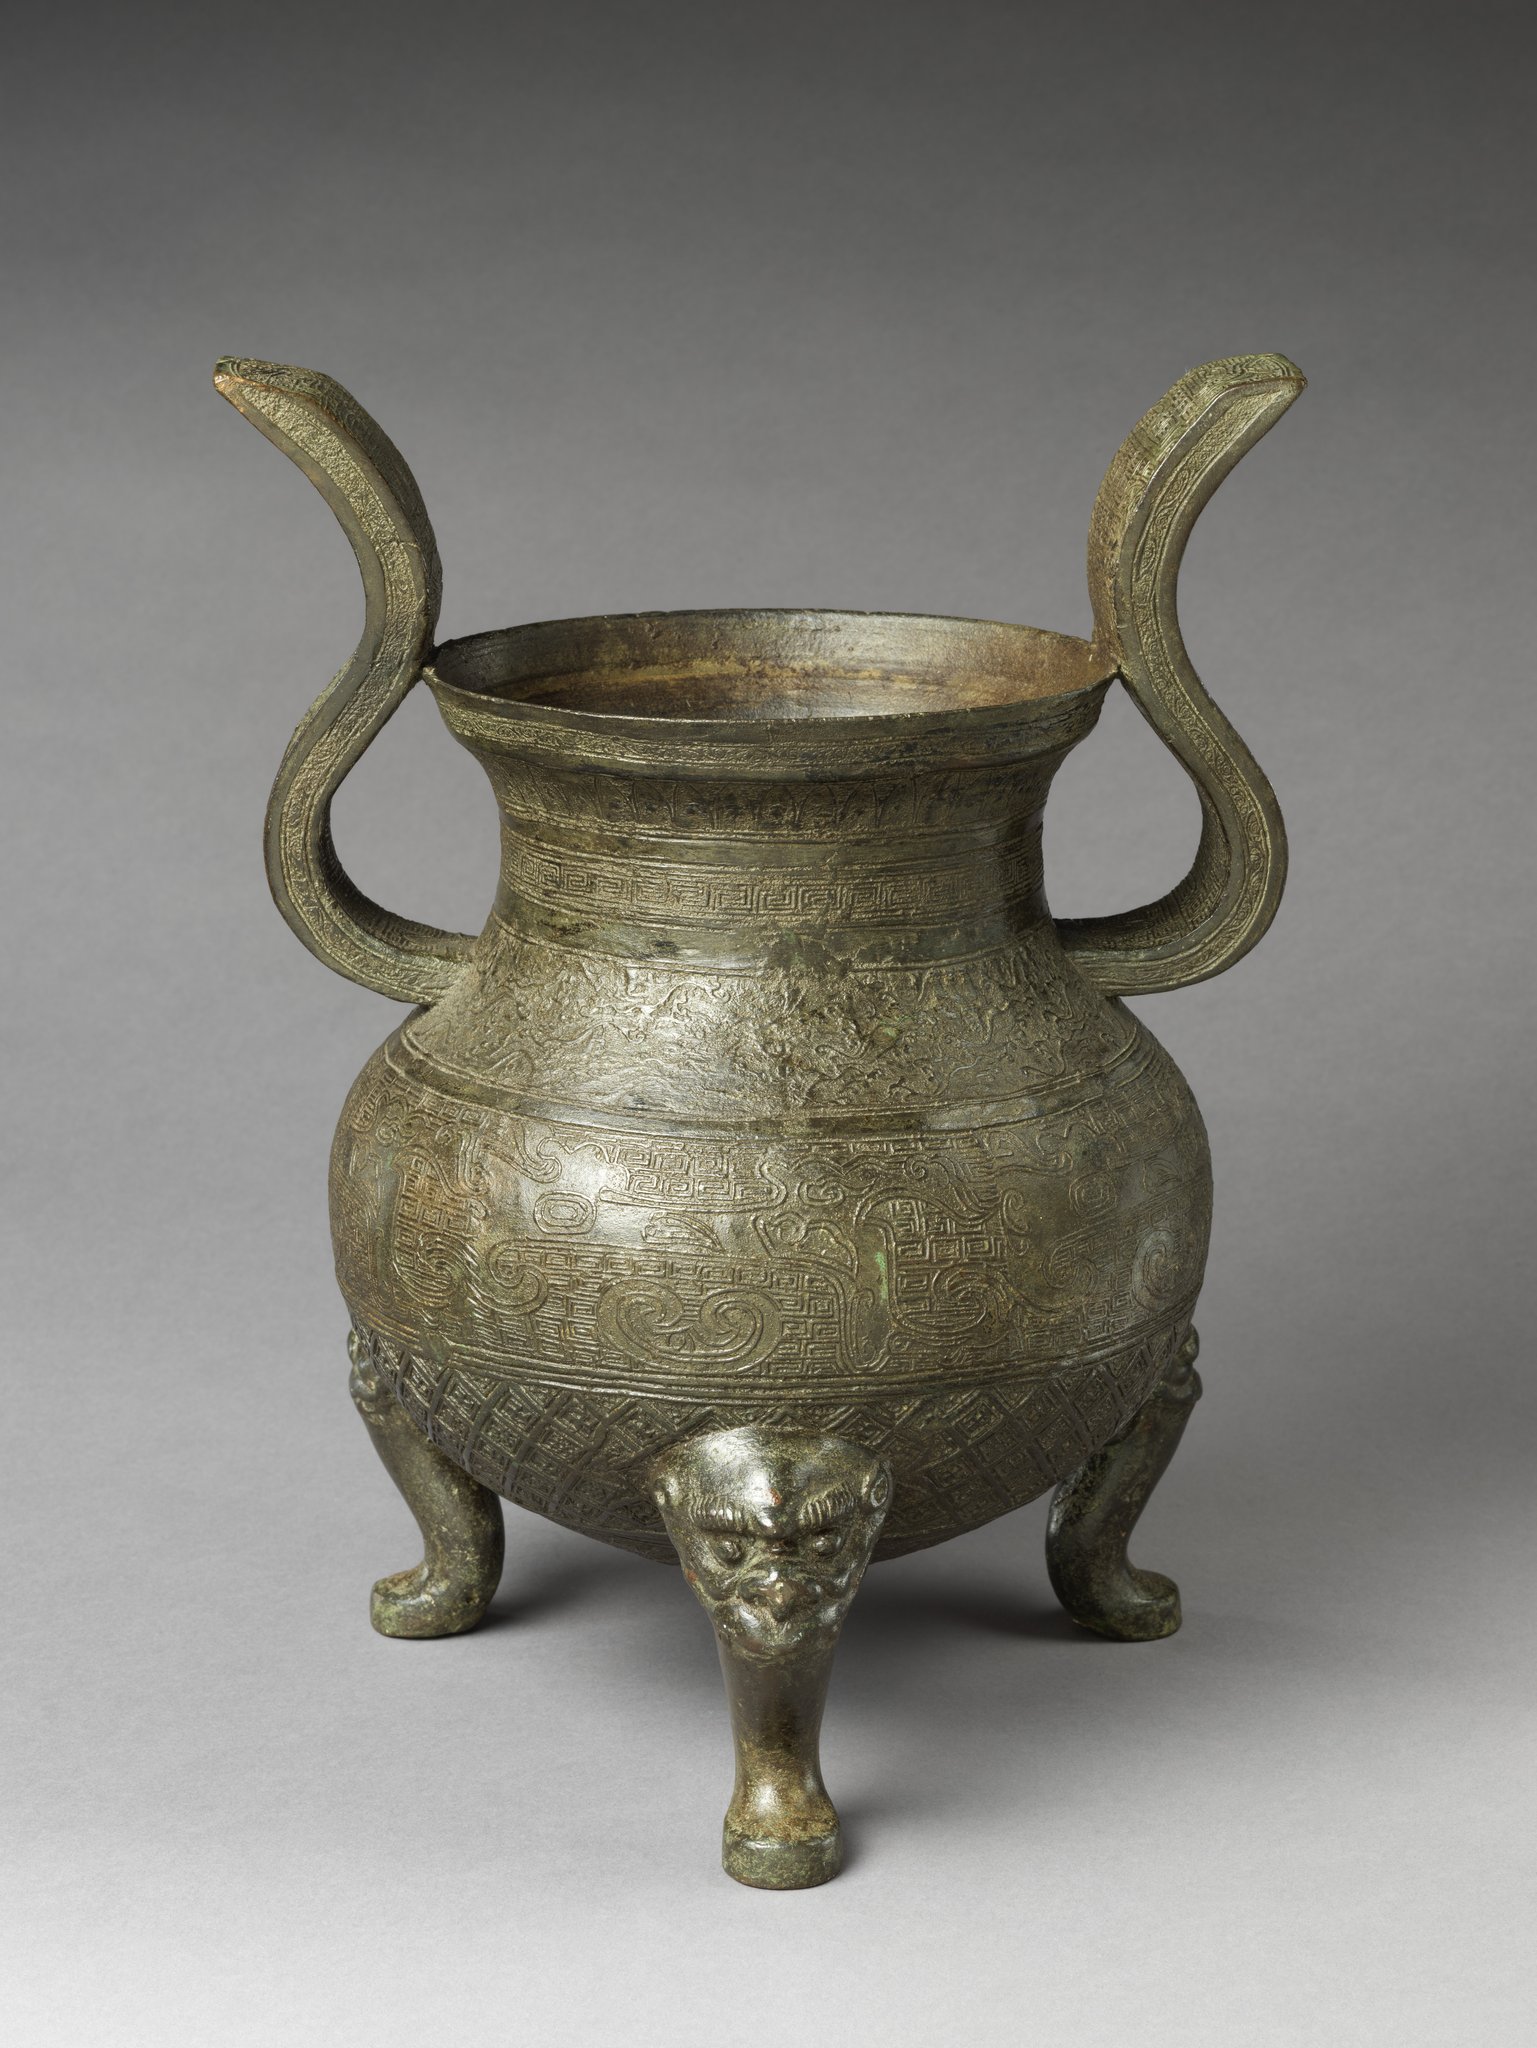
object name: censer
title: Tripod incense burner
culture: chinese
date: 1486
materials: copper alloy